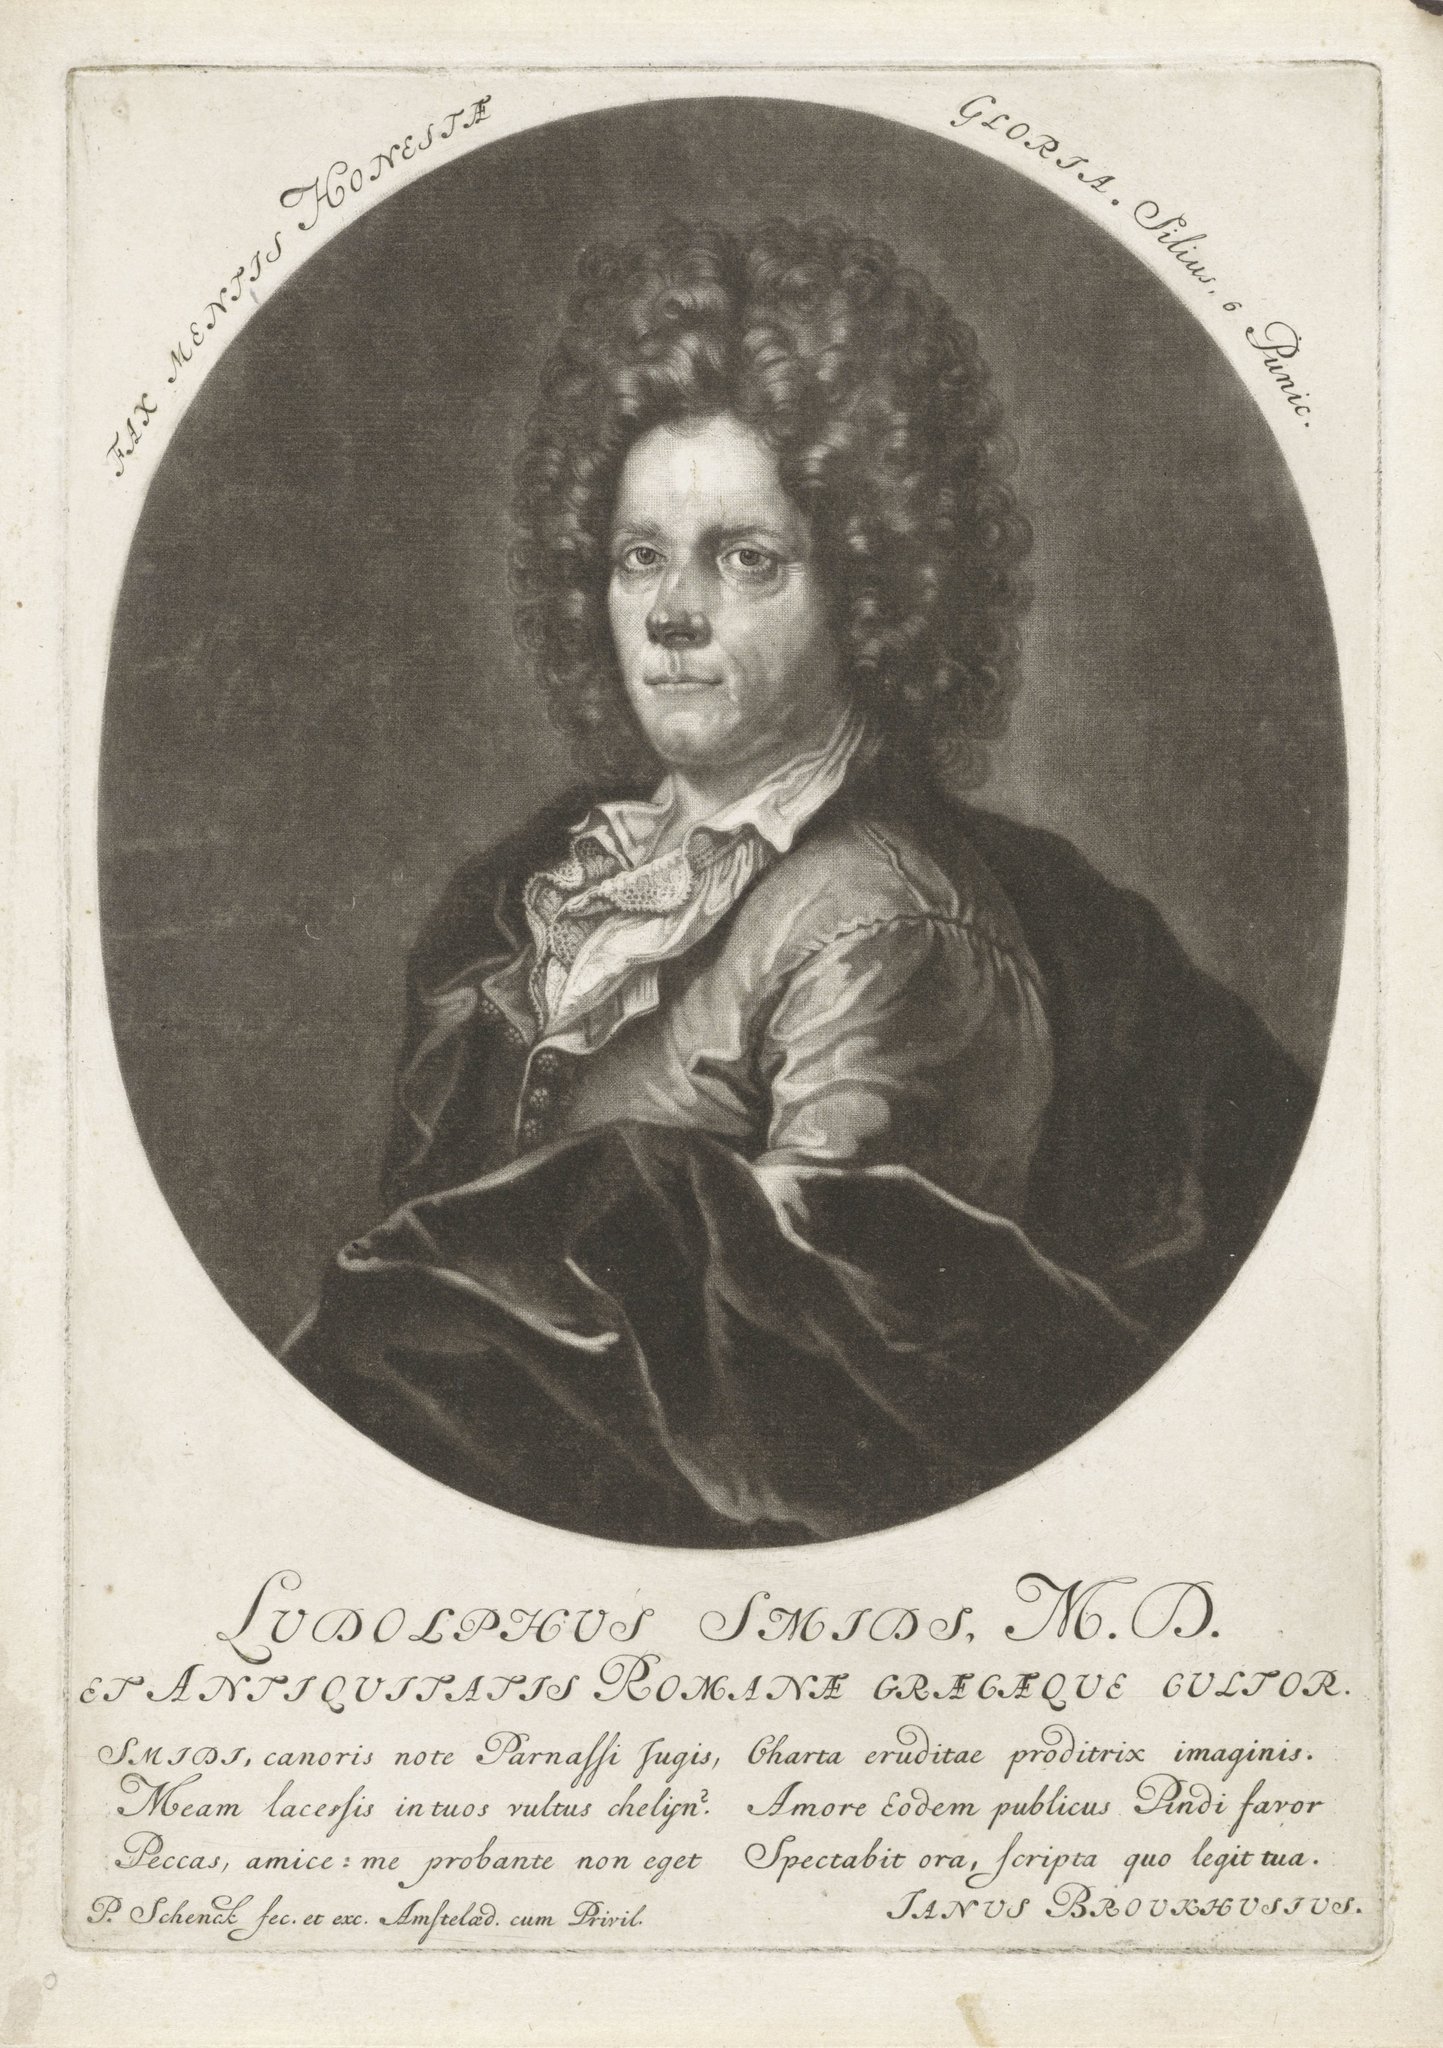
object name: print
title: Portret van Ludolph Smids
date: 1670-1713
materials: paper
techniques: mezzotint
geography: amsterdam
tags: ludolph smids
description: De dichter, oudheidkundige en arts Ludolph Smids.